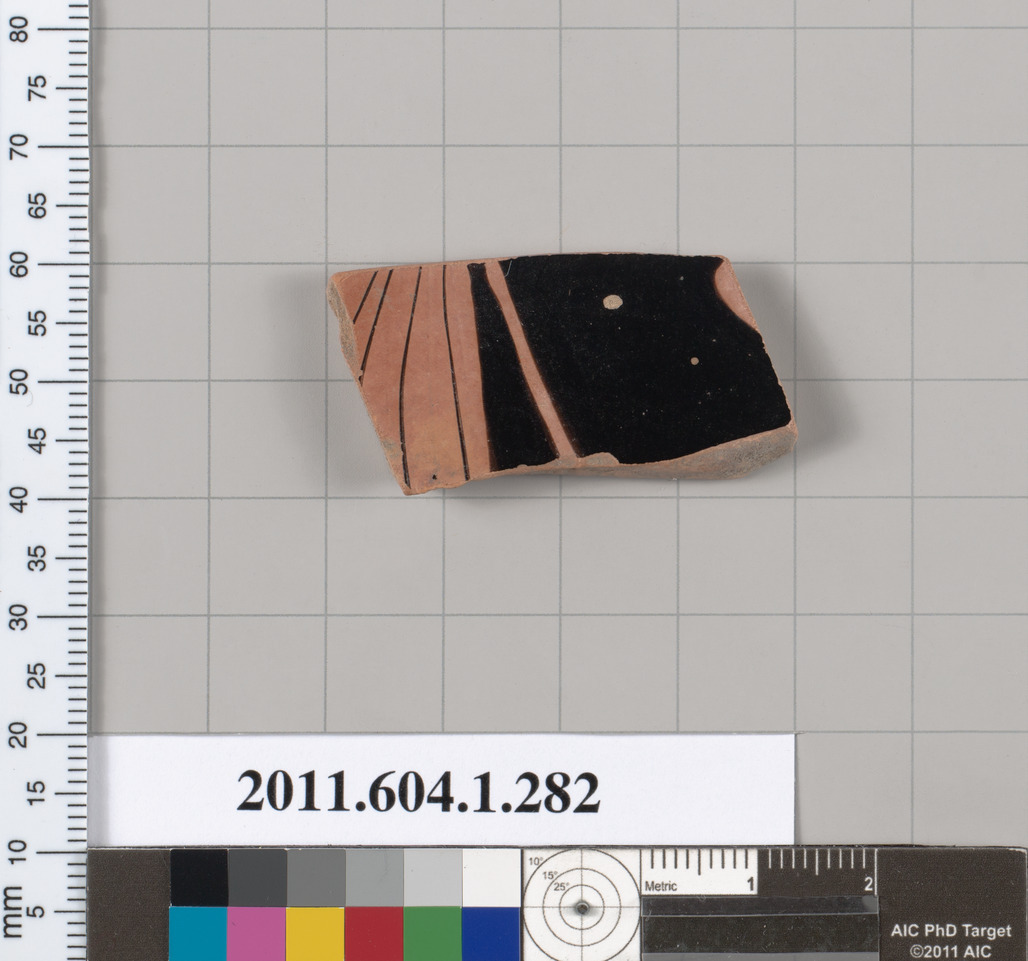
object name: kylix fragment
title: Terracotta fragment of a kylix (drinking cup)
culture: greek, attic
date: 475-451 BCE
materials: terracotta